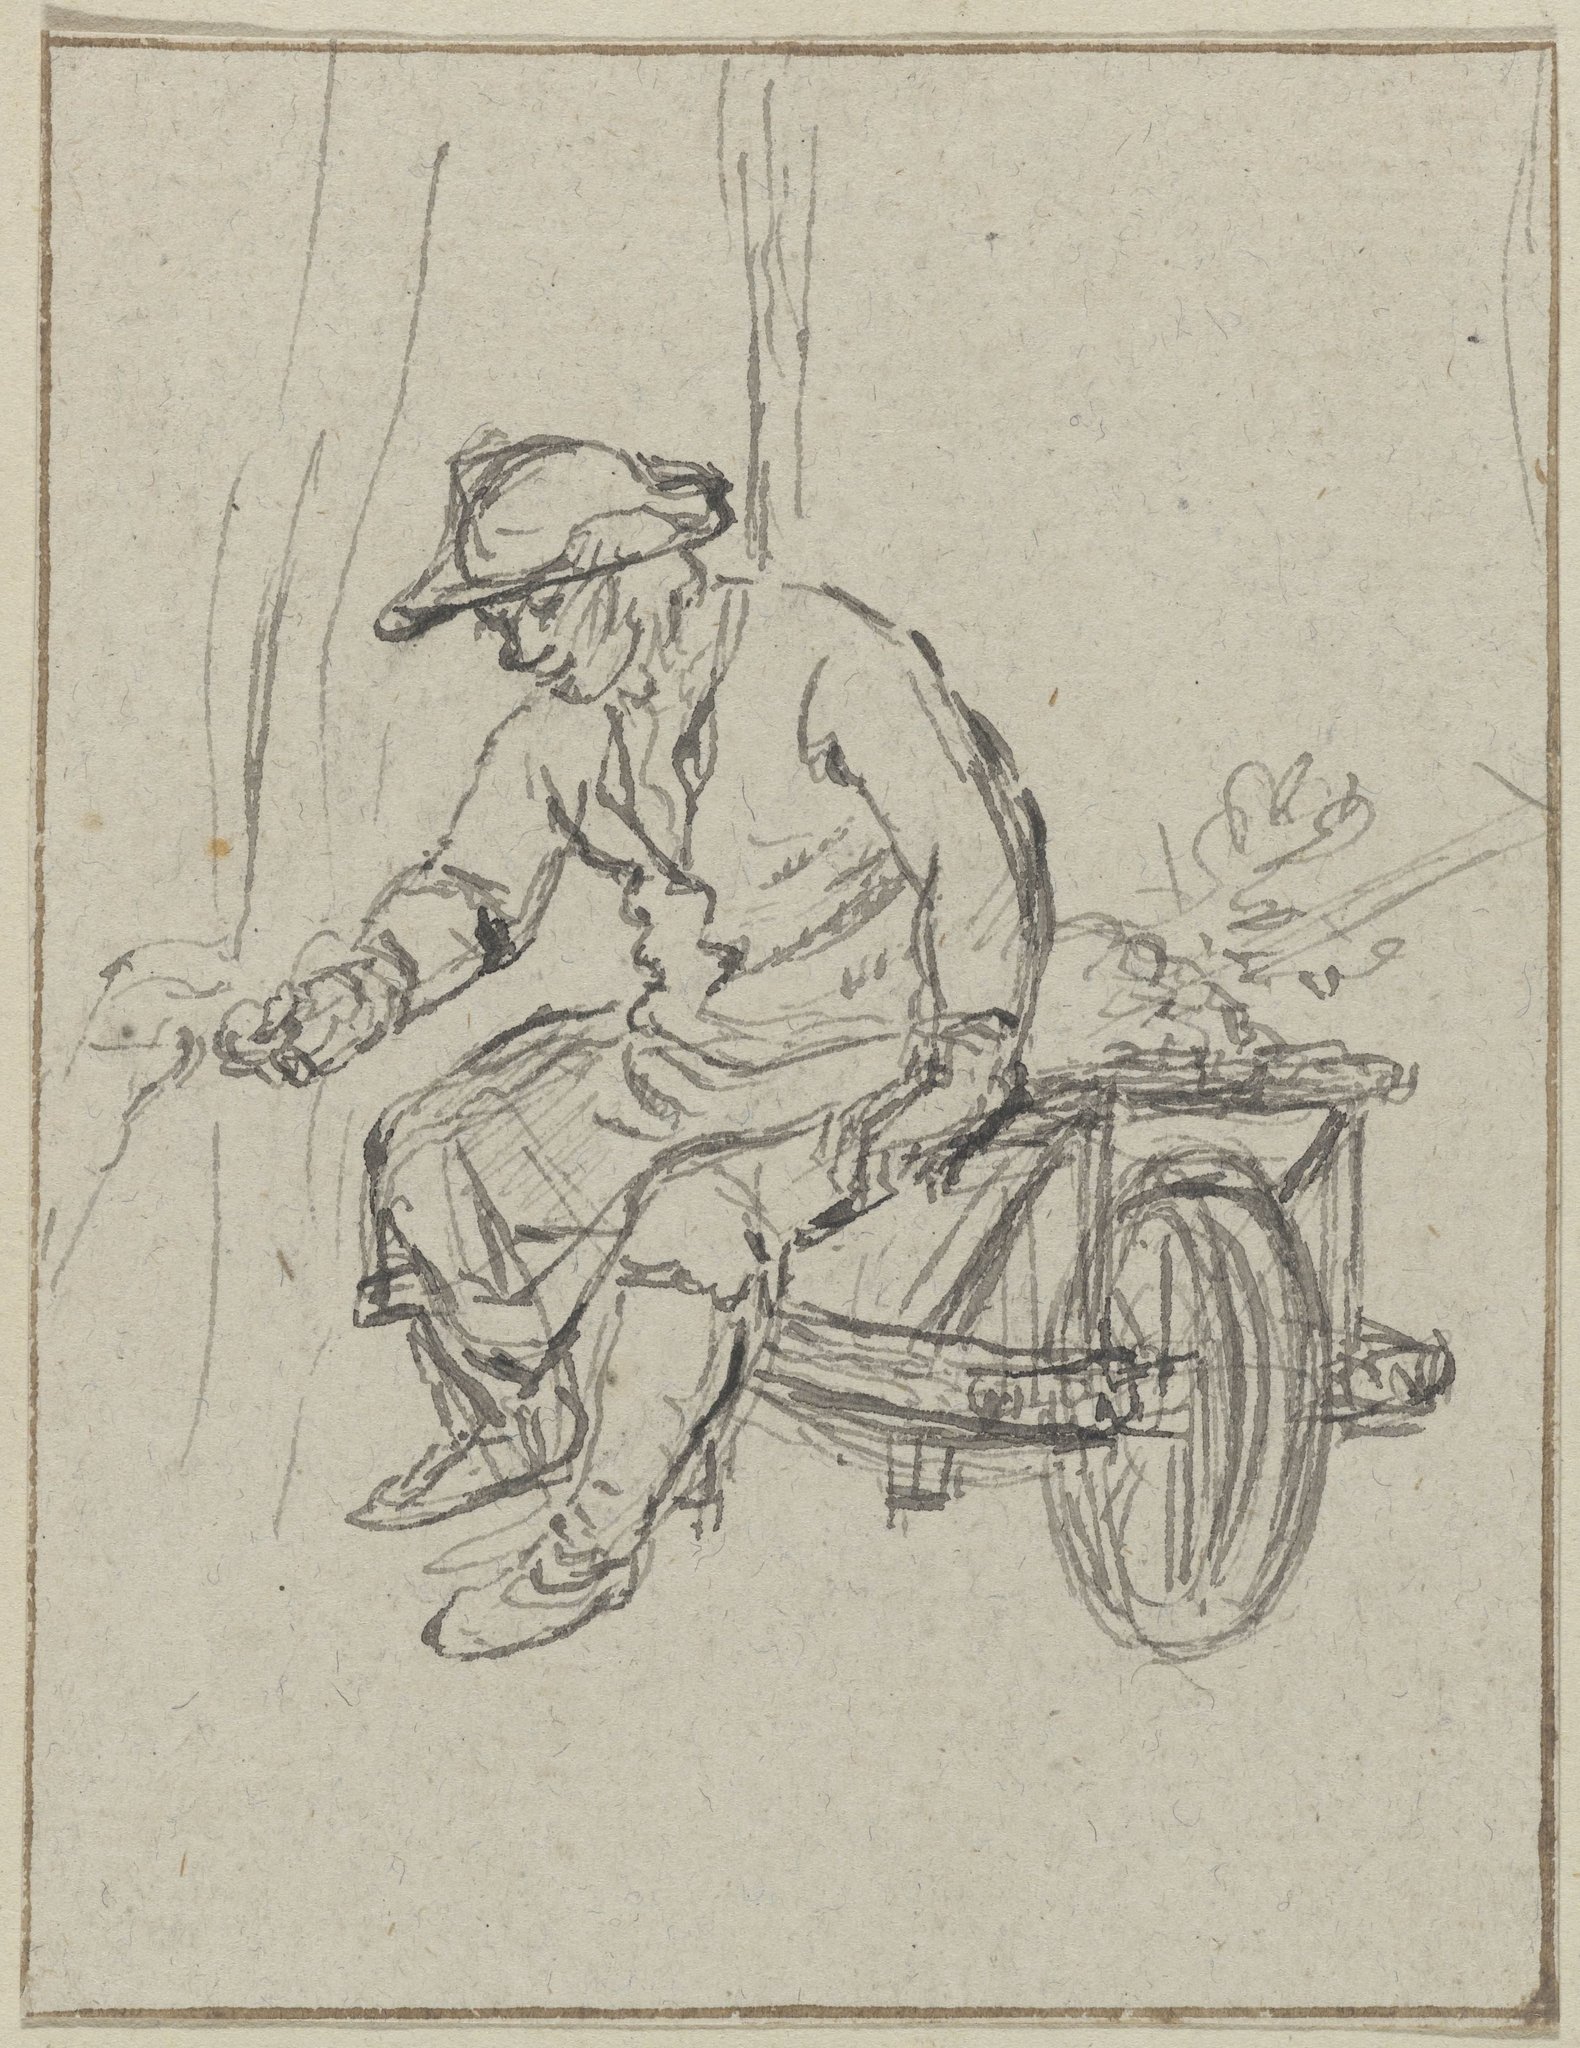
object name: drawing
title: Man met hoed zittend op een kruiwagen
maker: Anonymous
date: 1700-1799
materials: ink, paper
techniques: pen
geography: netherlands